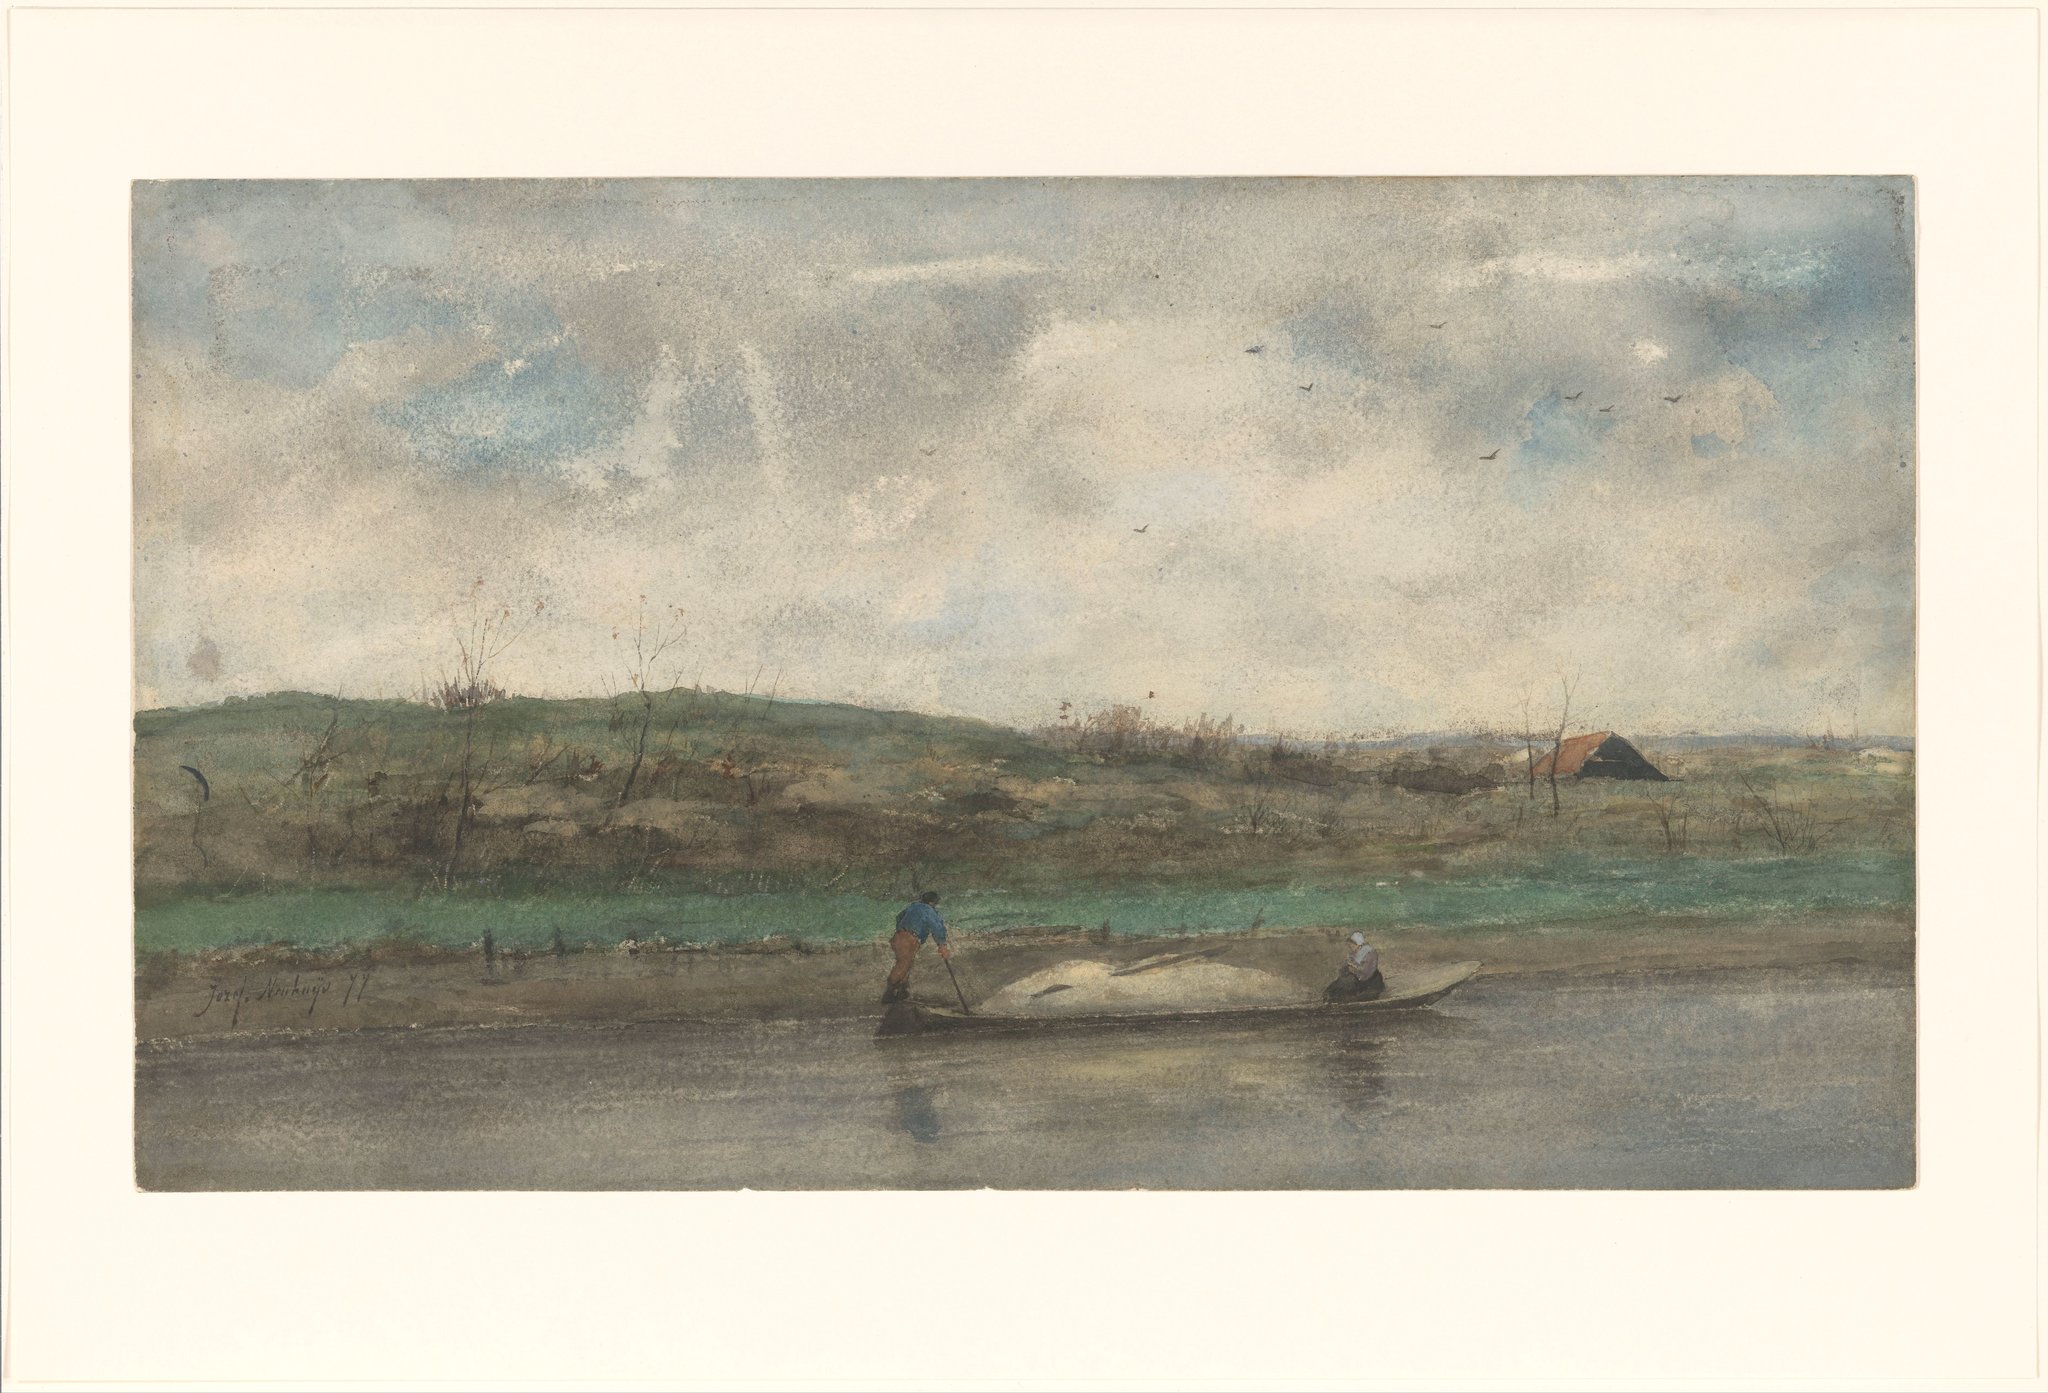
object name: watercolor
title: Zandschuit in vaart door glooiend landschap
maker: jozef neuhuys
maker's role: draughtsman, painter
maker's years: 1841-1889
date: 1877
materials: paper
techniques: brush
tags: tow-boat, towing-barge (+ view ~ vehicle, ship, etc.)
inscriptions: date